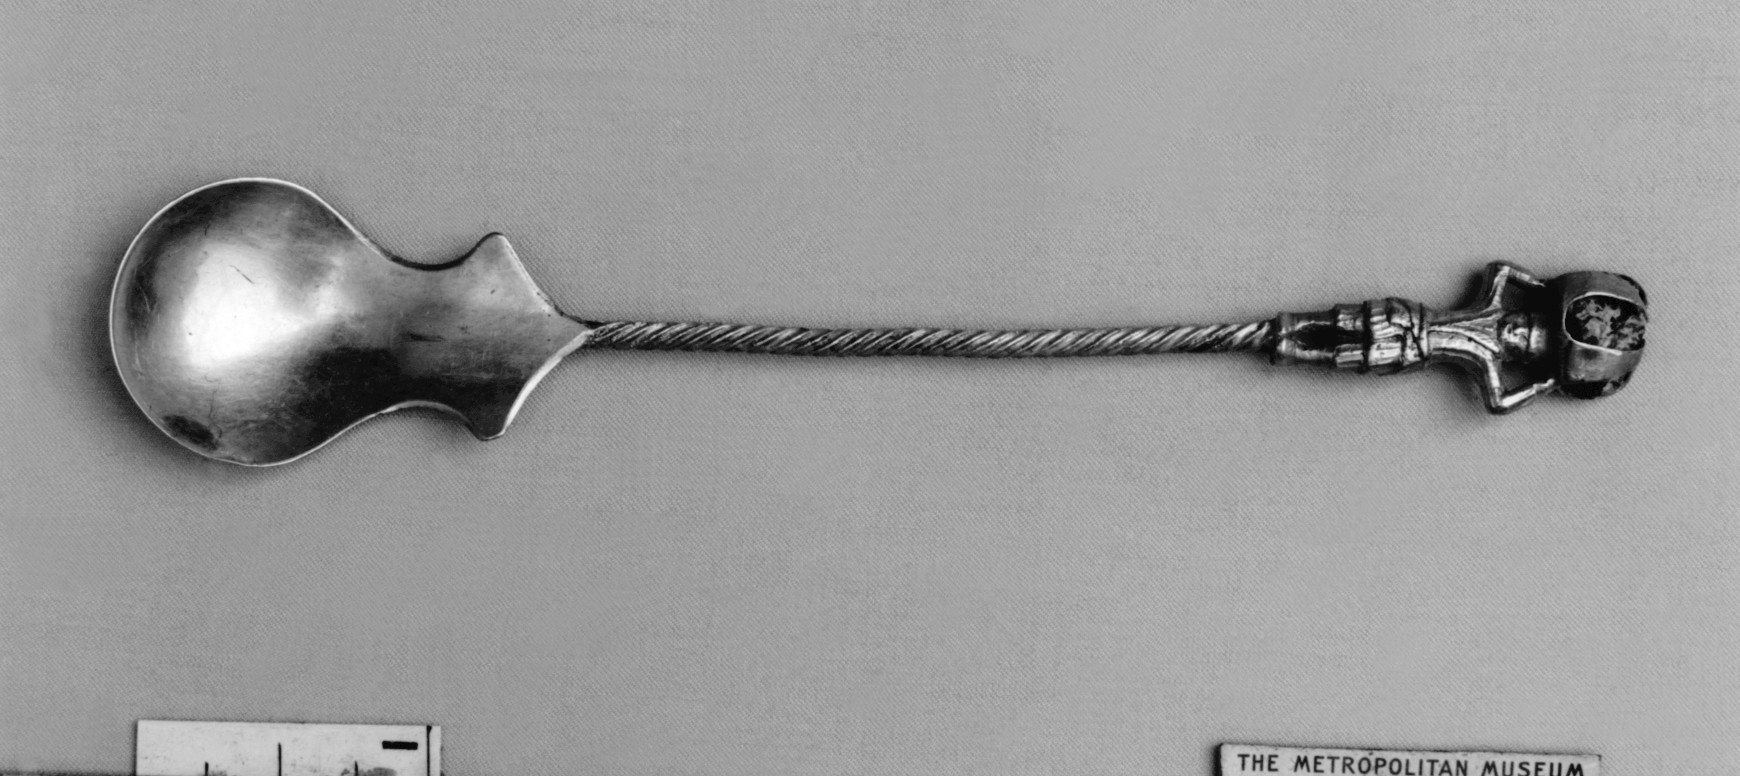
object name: spoon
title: Figure-top spoon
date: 1701-1800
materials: gilt, silver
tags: men